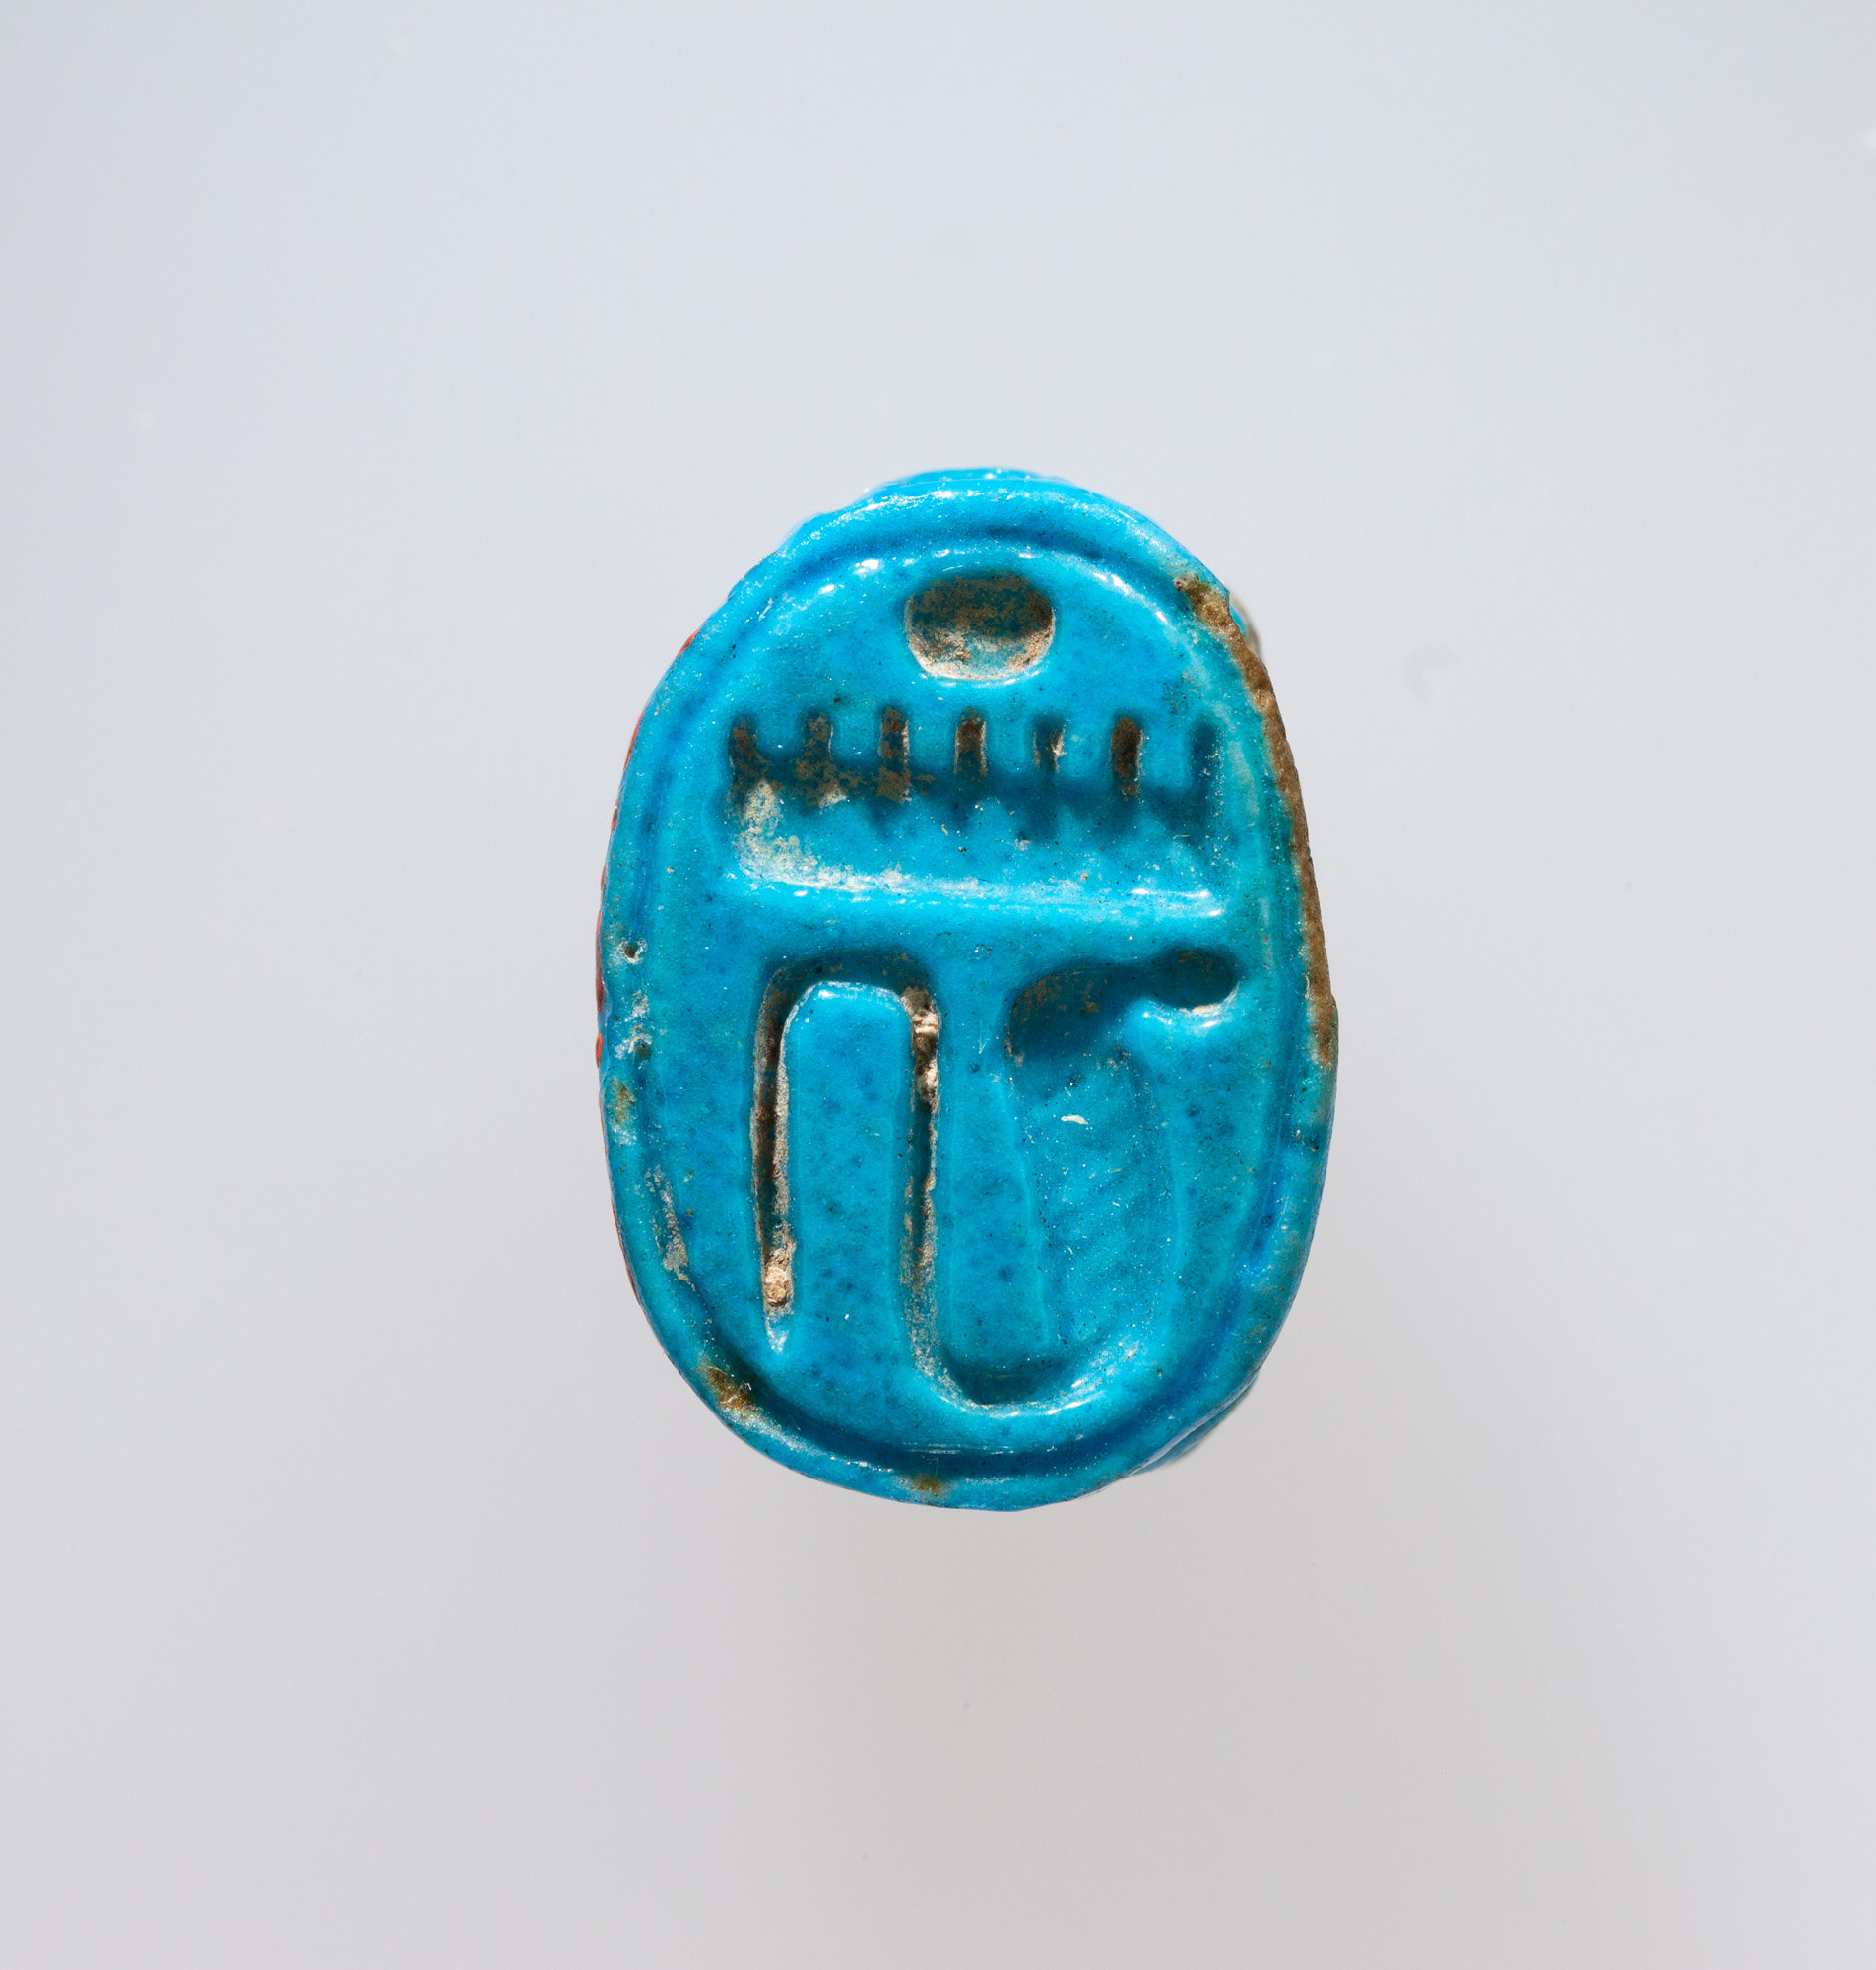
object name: scarab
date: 1479-1458 BCE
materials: faience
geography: egypt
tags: hieroglyphs,scarabs